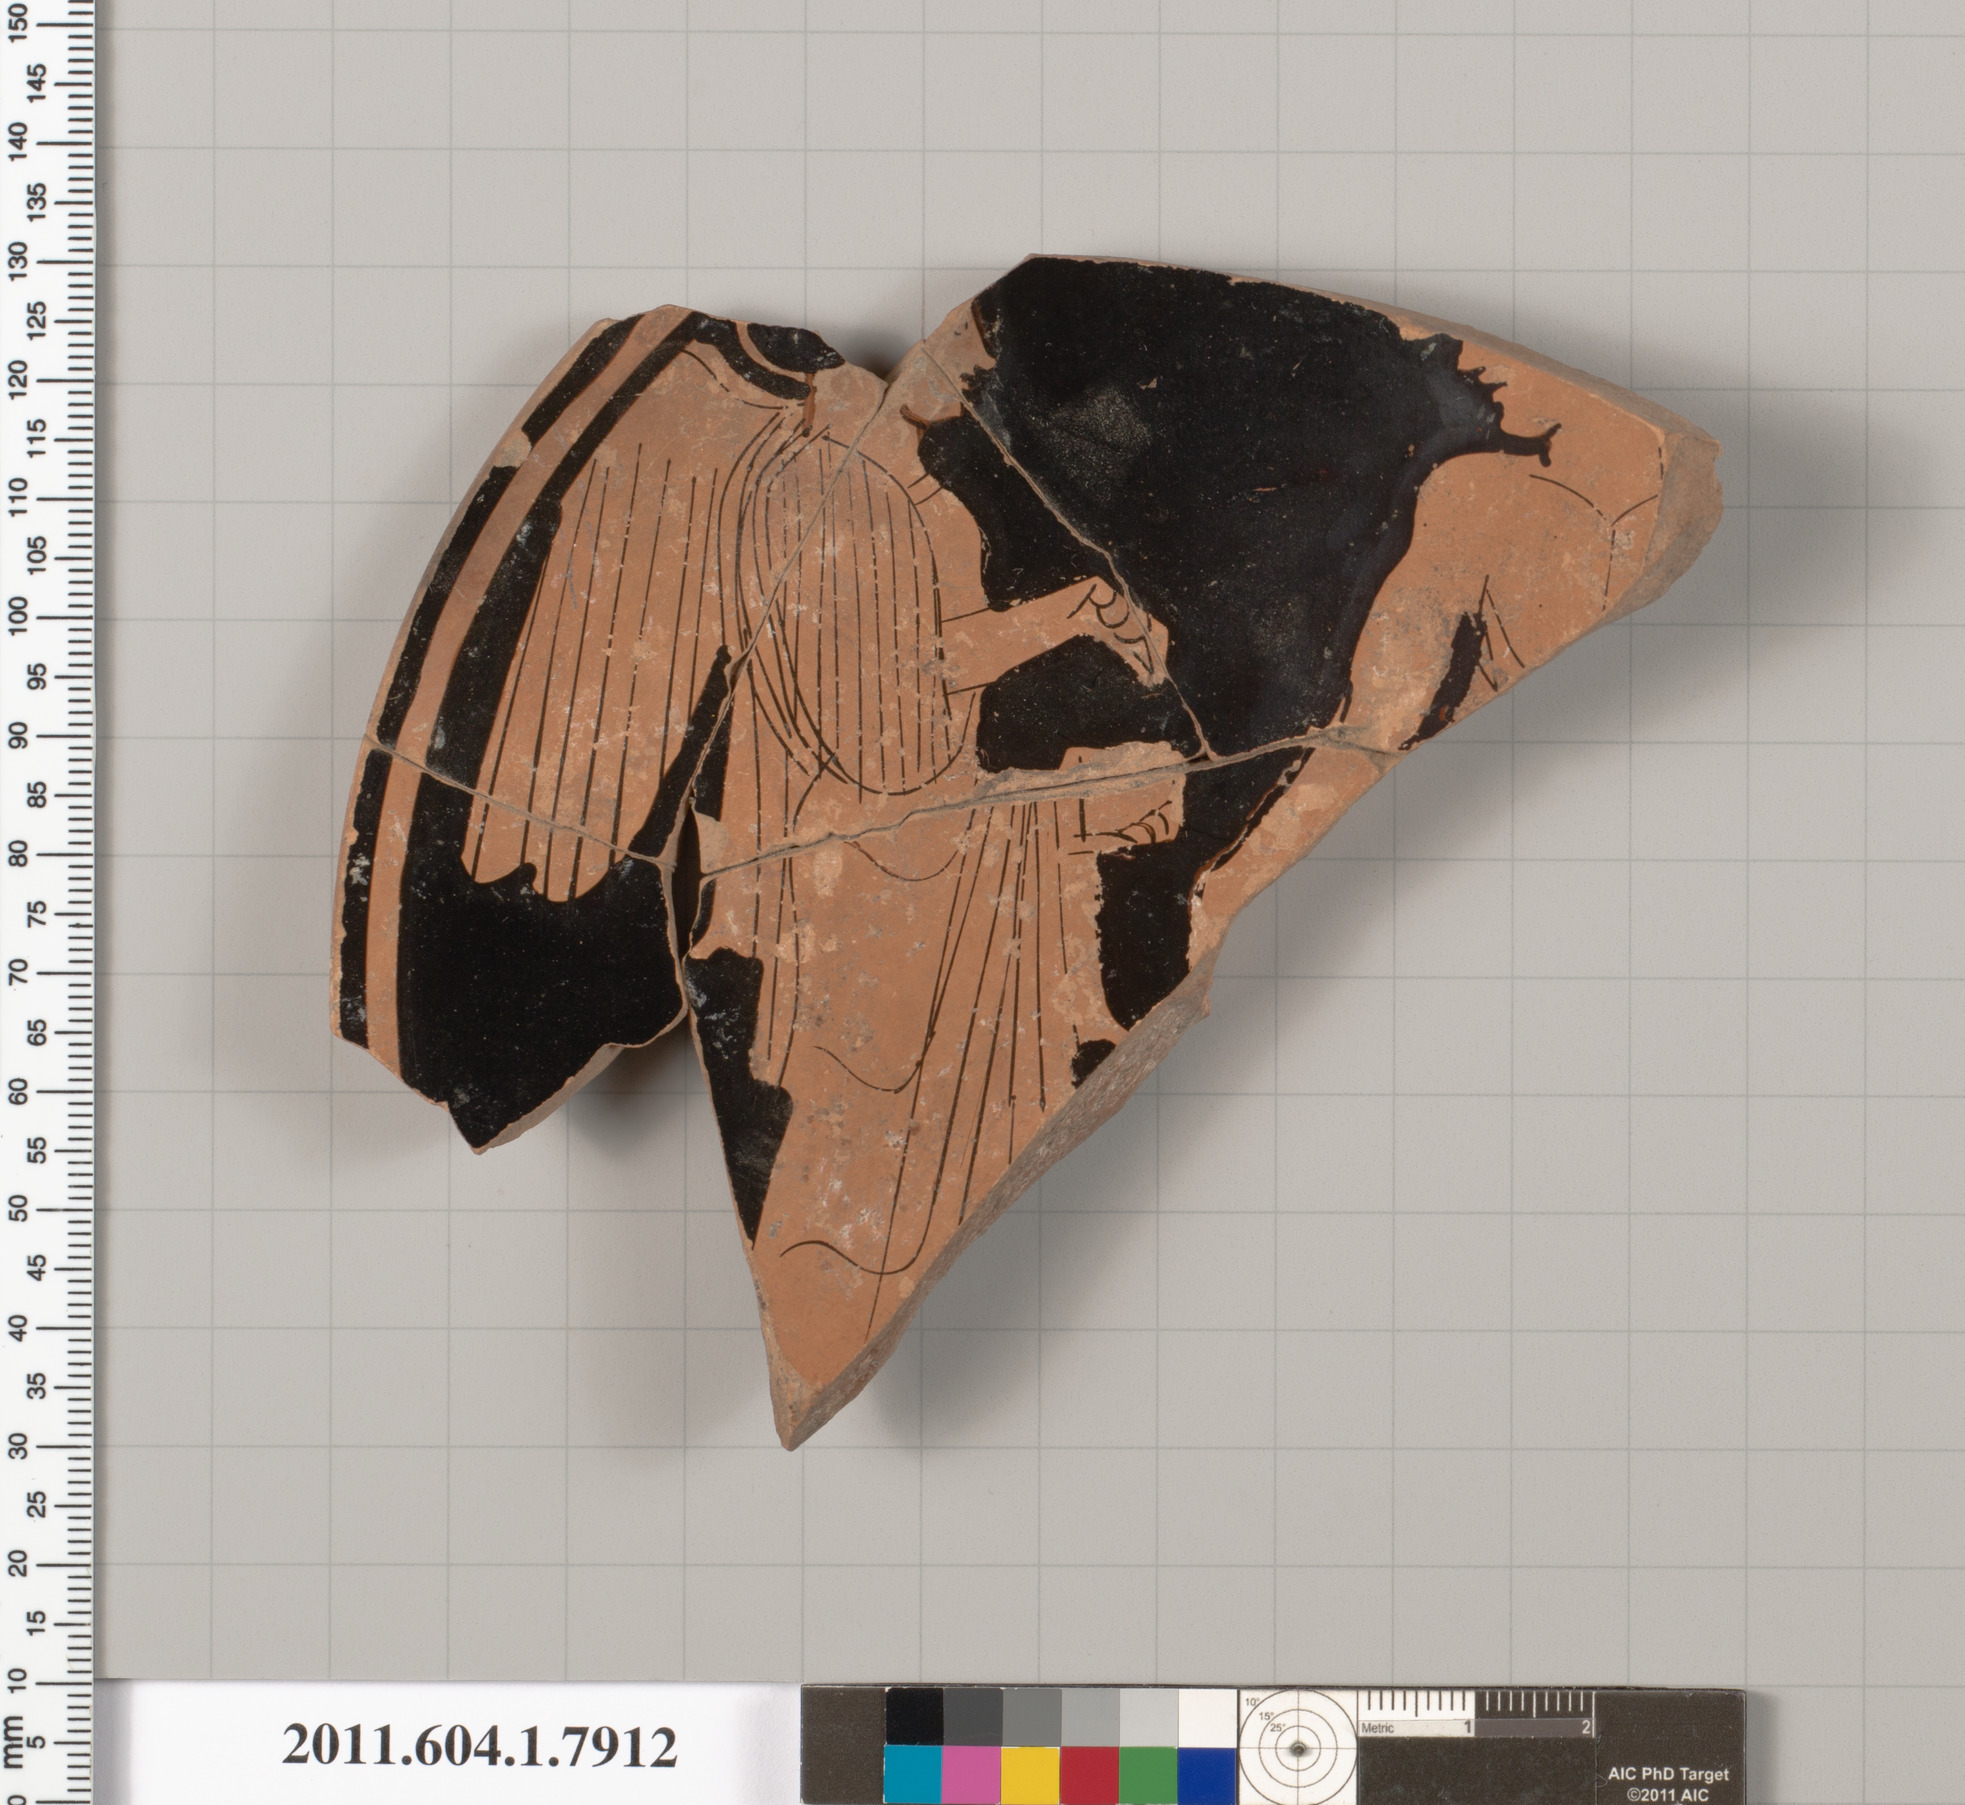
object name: kylix fragment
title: Terracotta fragment of a kylix (drinking cup)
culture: greek, attic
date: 467-435 BCE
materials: terracotta